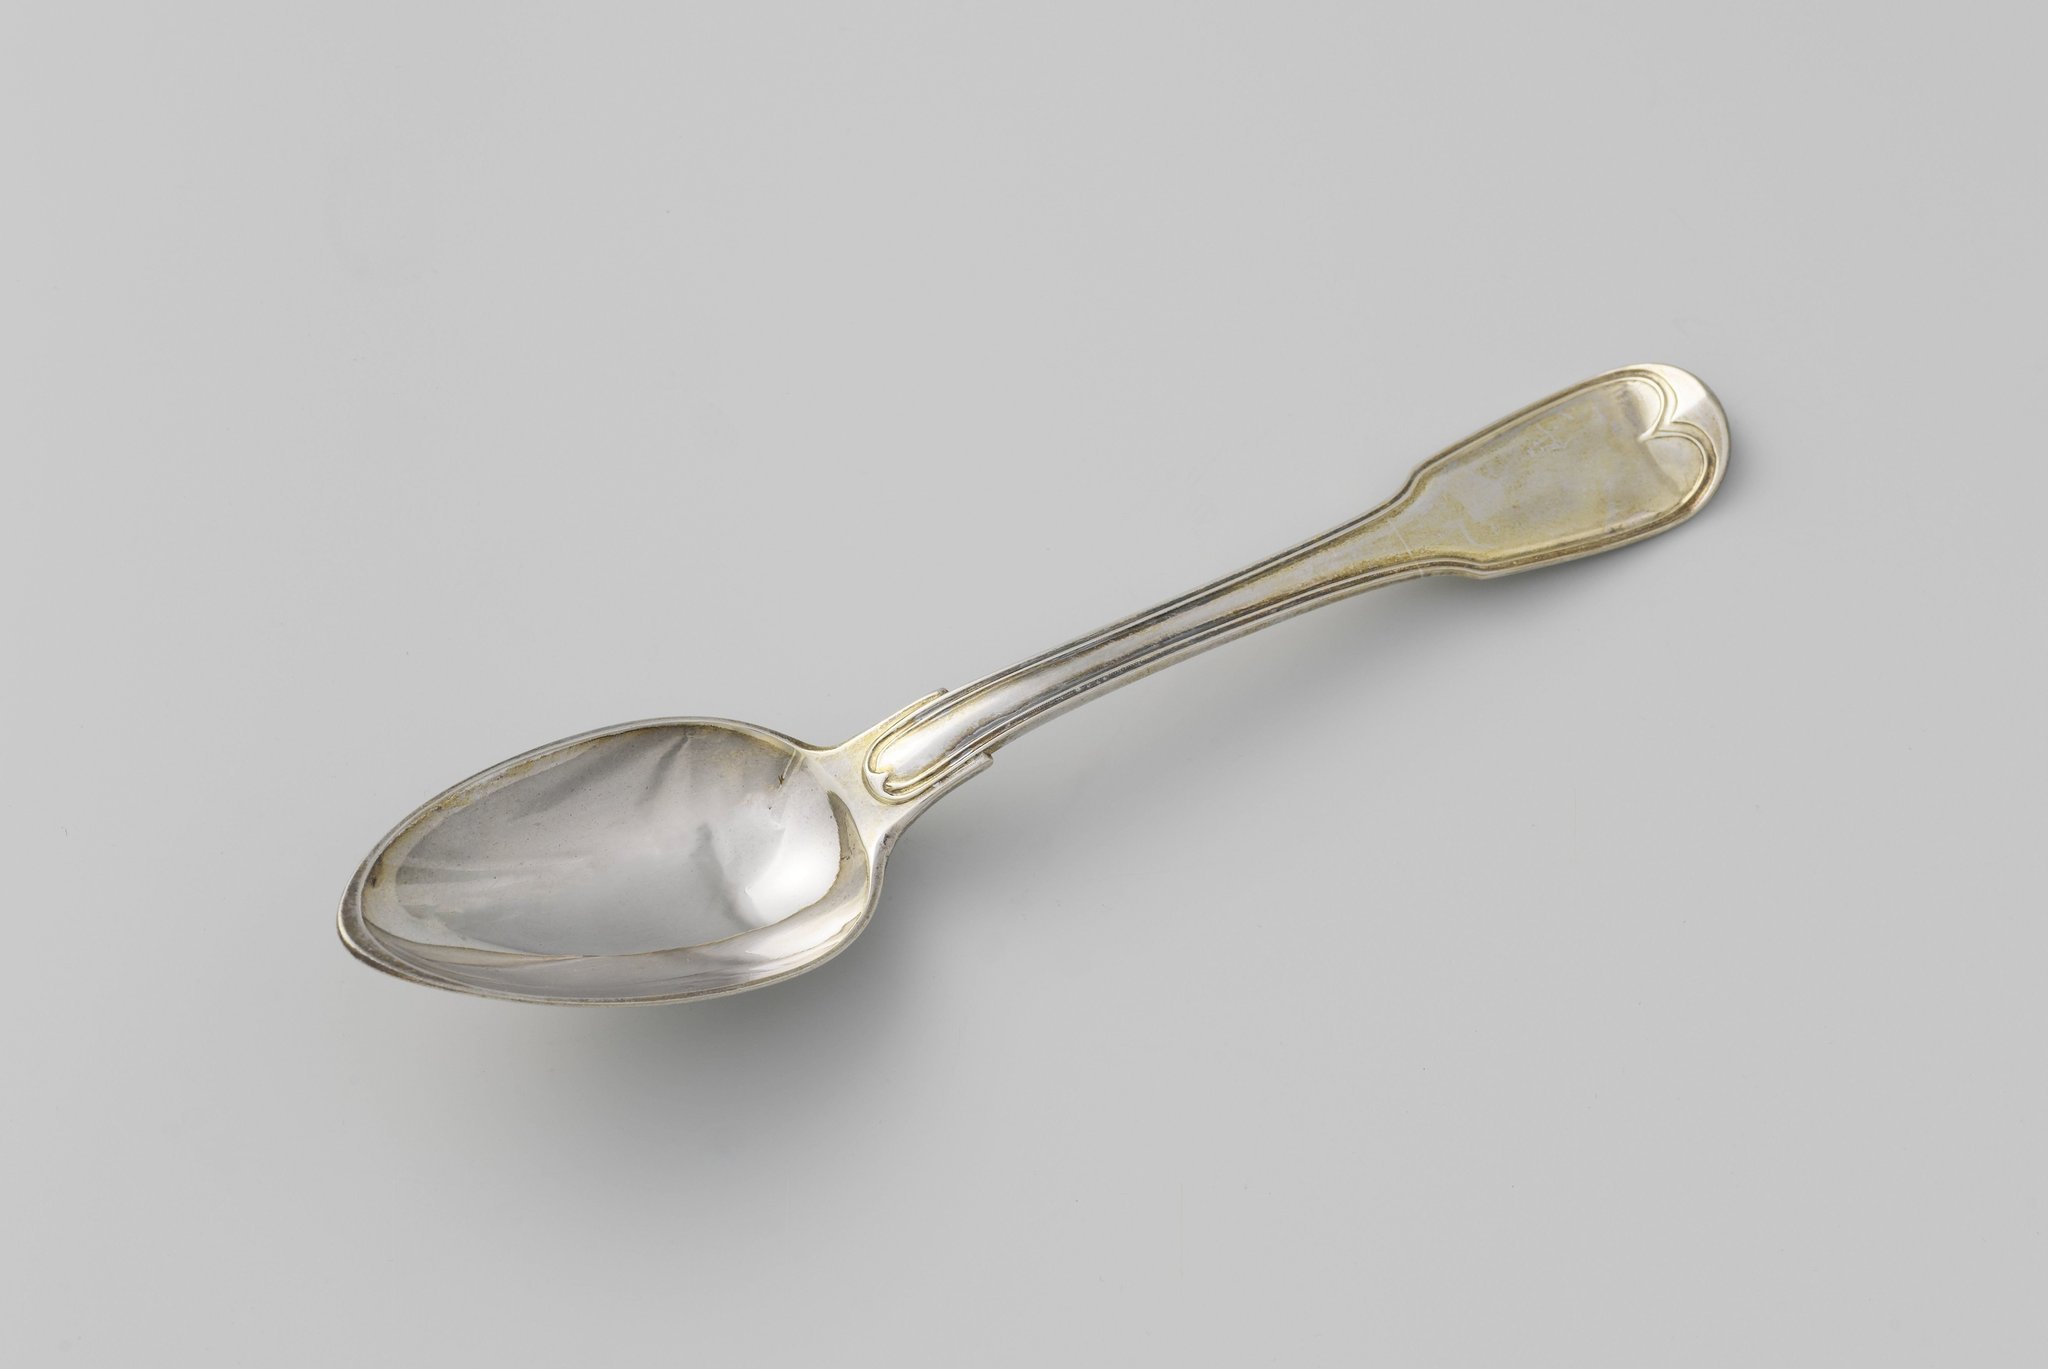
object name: spoon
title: Lepel met het helmteken Clifford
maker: hendrik helweg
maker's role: silversmith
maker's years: 1802-1858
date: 1832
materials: silver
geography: amsterdam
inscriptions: alloy mark, assay office mark, maker's mark, date letter: ‘X’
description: De eivormige bak van de lepel is aan zowel boven- als onderzijde door middel van enkel lof verbonden met de platte, gebogen steel, die zich verbreedt naar het spatelvormige uiteinde. Boven- en onderzijde van de steel worden omgeven door een dubbele filetrand, die bij het uiteinde ingezwenkt is. Op de onderzijde van de spatel is het helmteken Clifford gegraveerd.